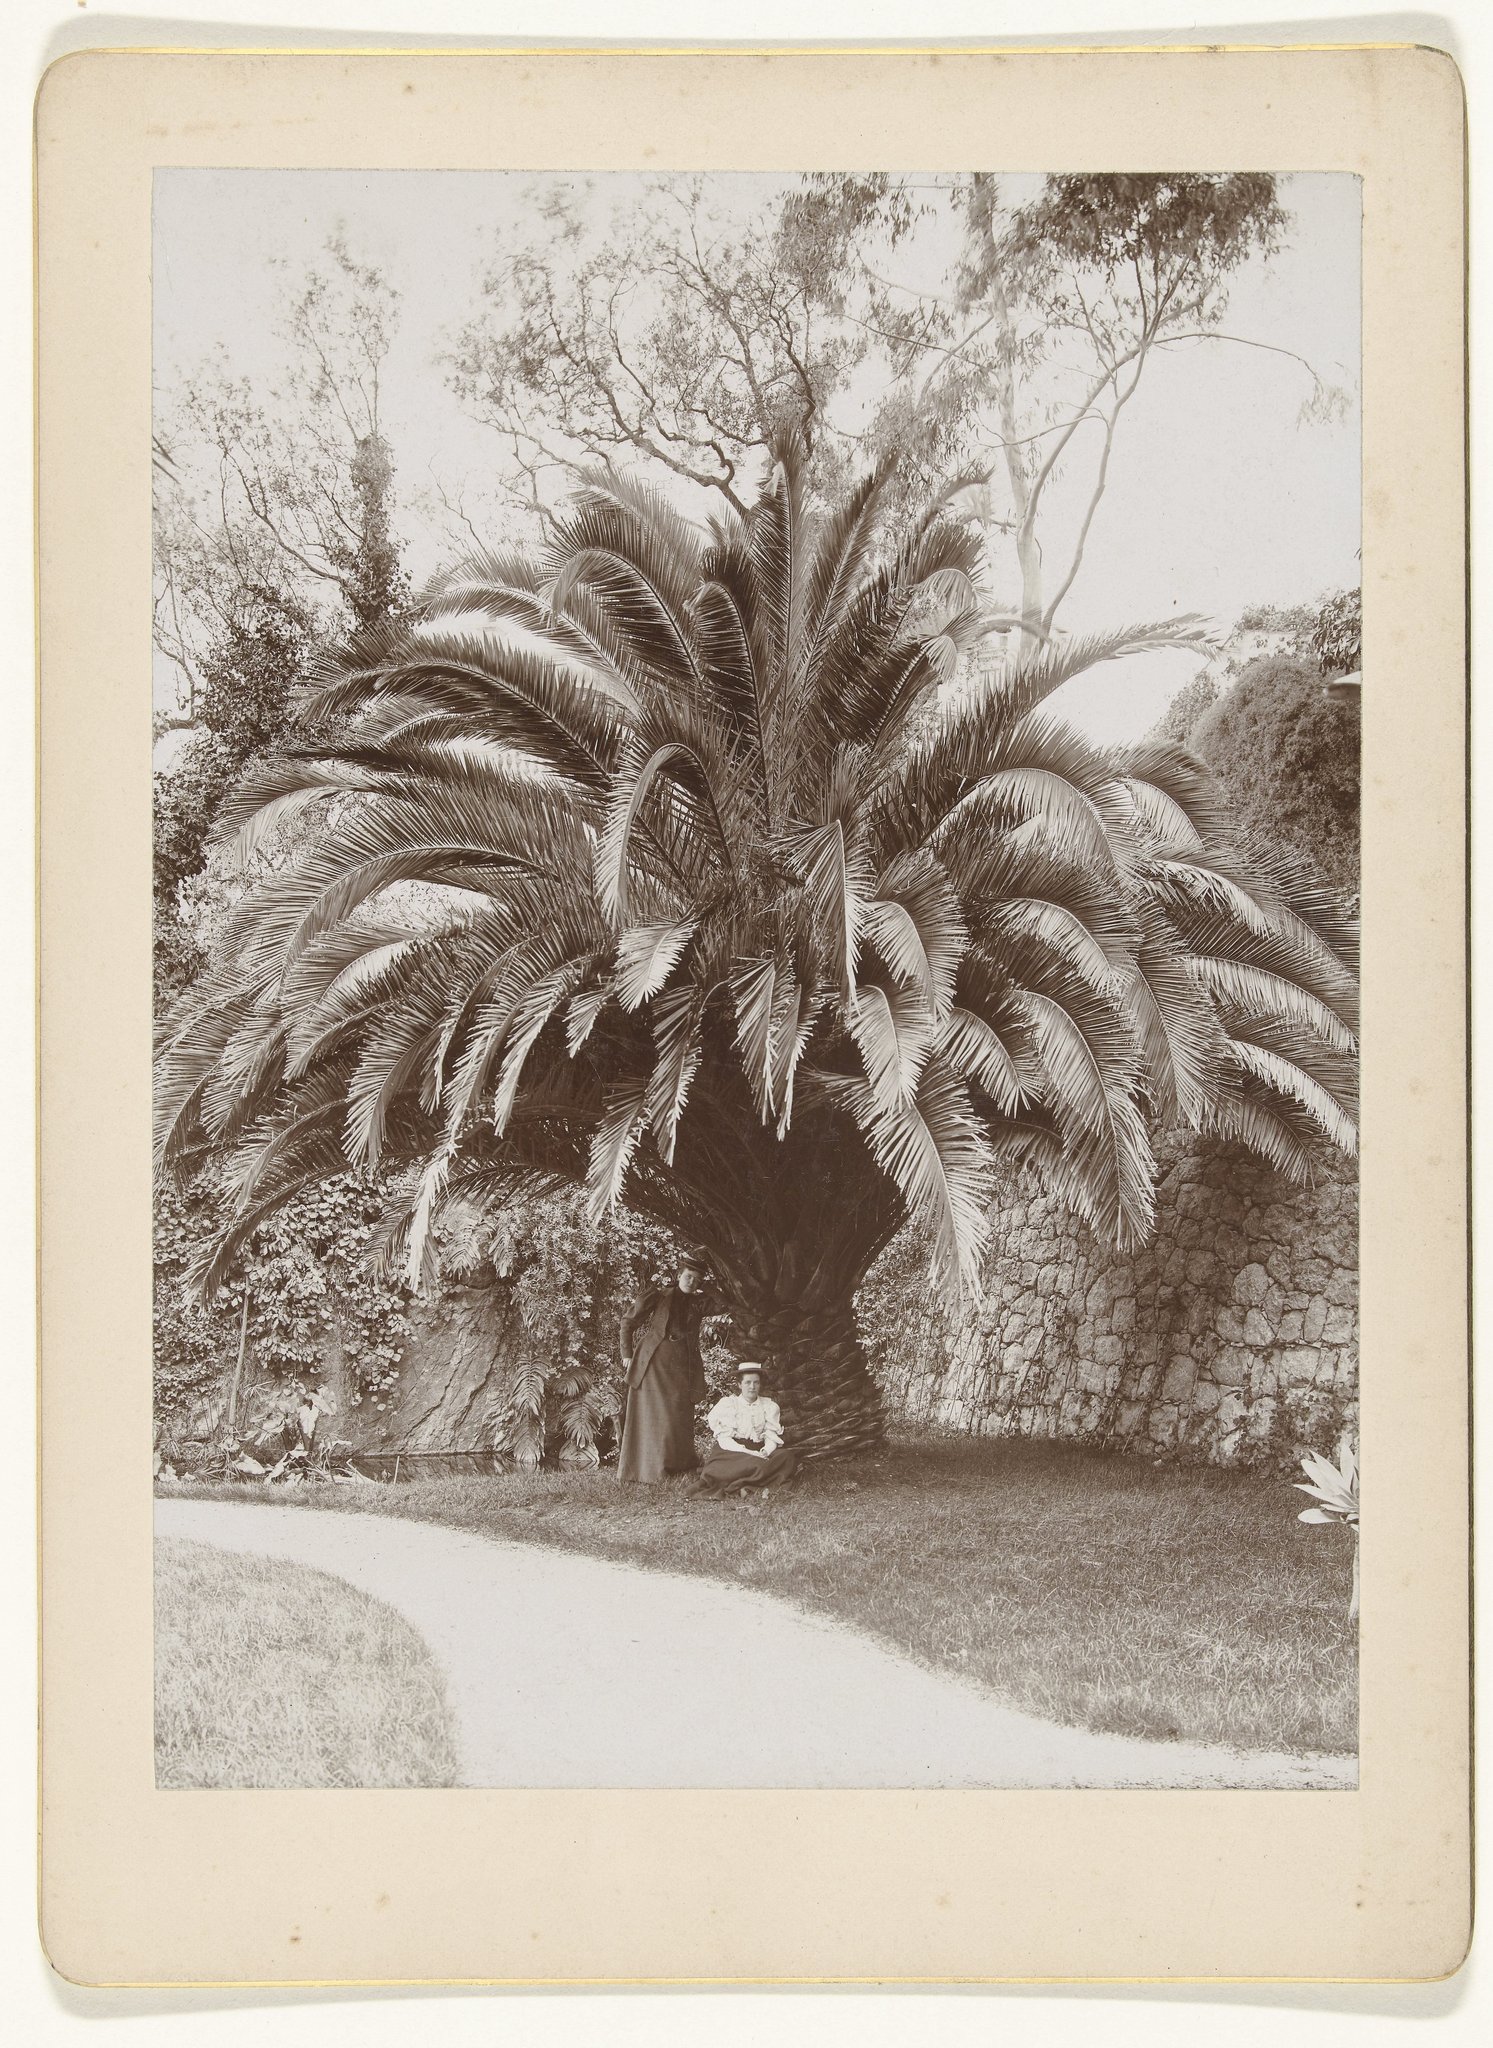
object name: photograph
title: Twee vrouwen onder een palmboom.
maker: henry pauw van wieldrecht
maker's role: fotograaf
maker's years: 1863-1912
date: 1896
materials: cardboard, photographic support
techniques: gelatin silver print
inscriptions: annotation: ‘No. 1133. 1896.’